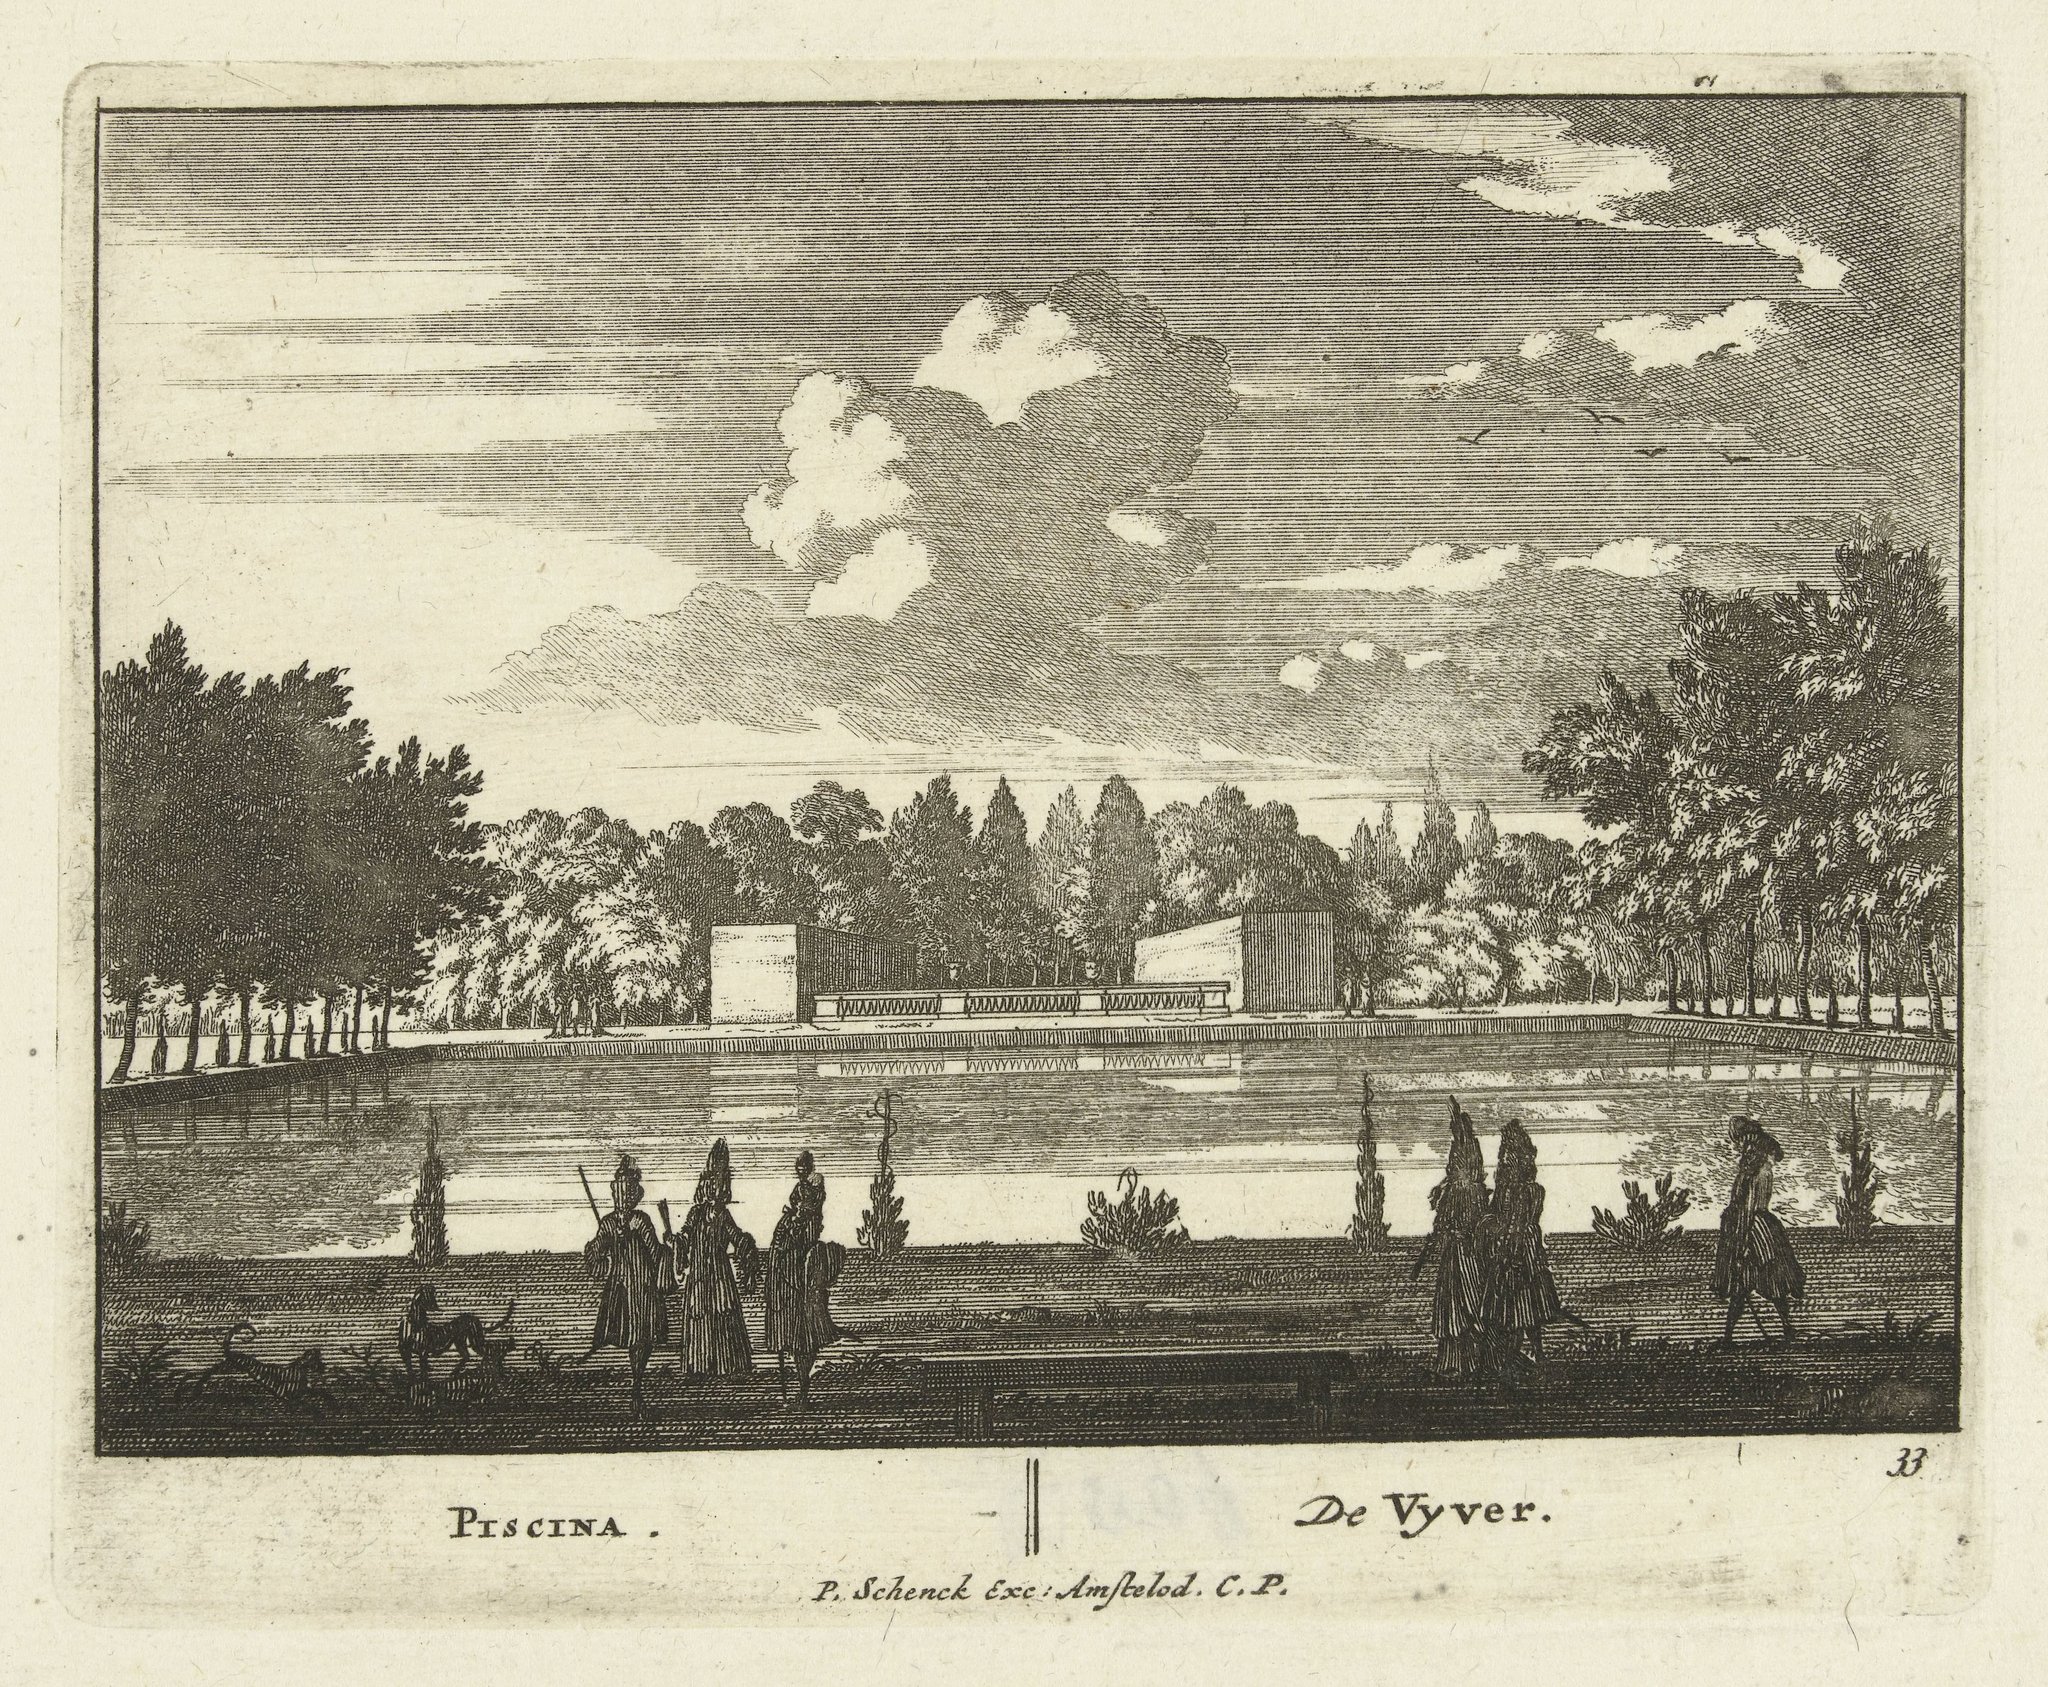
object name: print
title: Uitgeleesene Gesichte van het Wijdvermaarde Loo als andere vorstelijke Huisen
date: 1695-1705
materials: paper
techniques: etching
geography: amsterdam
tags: french or architectonic garden; formal garden, garden pond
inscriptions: collector's mark: Lugt 2228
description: Prent uit een serie van 71 prenten met Rijnlandschappen, gezichten op vorstelijke paleizen en stadsgezichten uit Den Haag en Amsterdam.